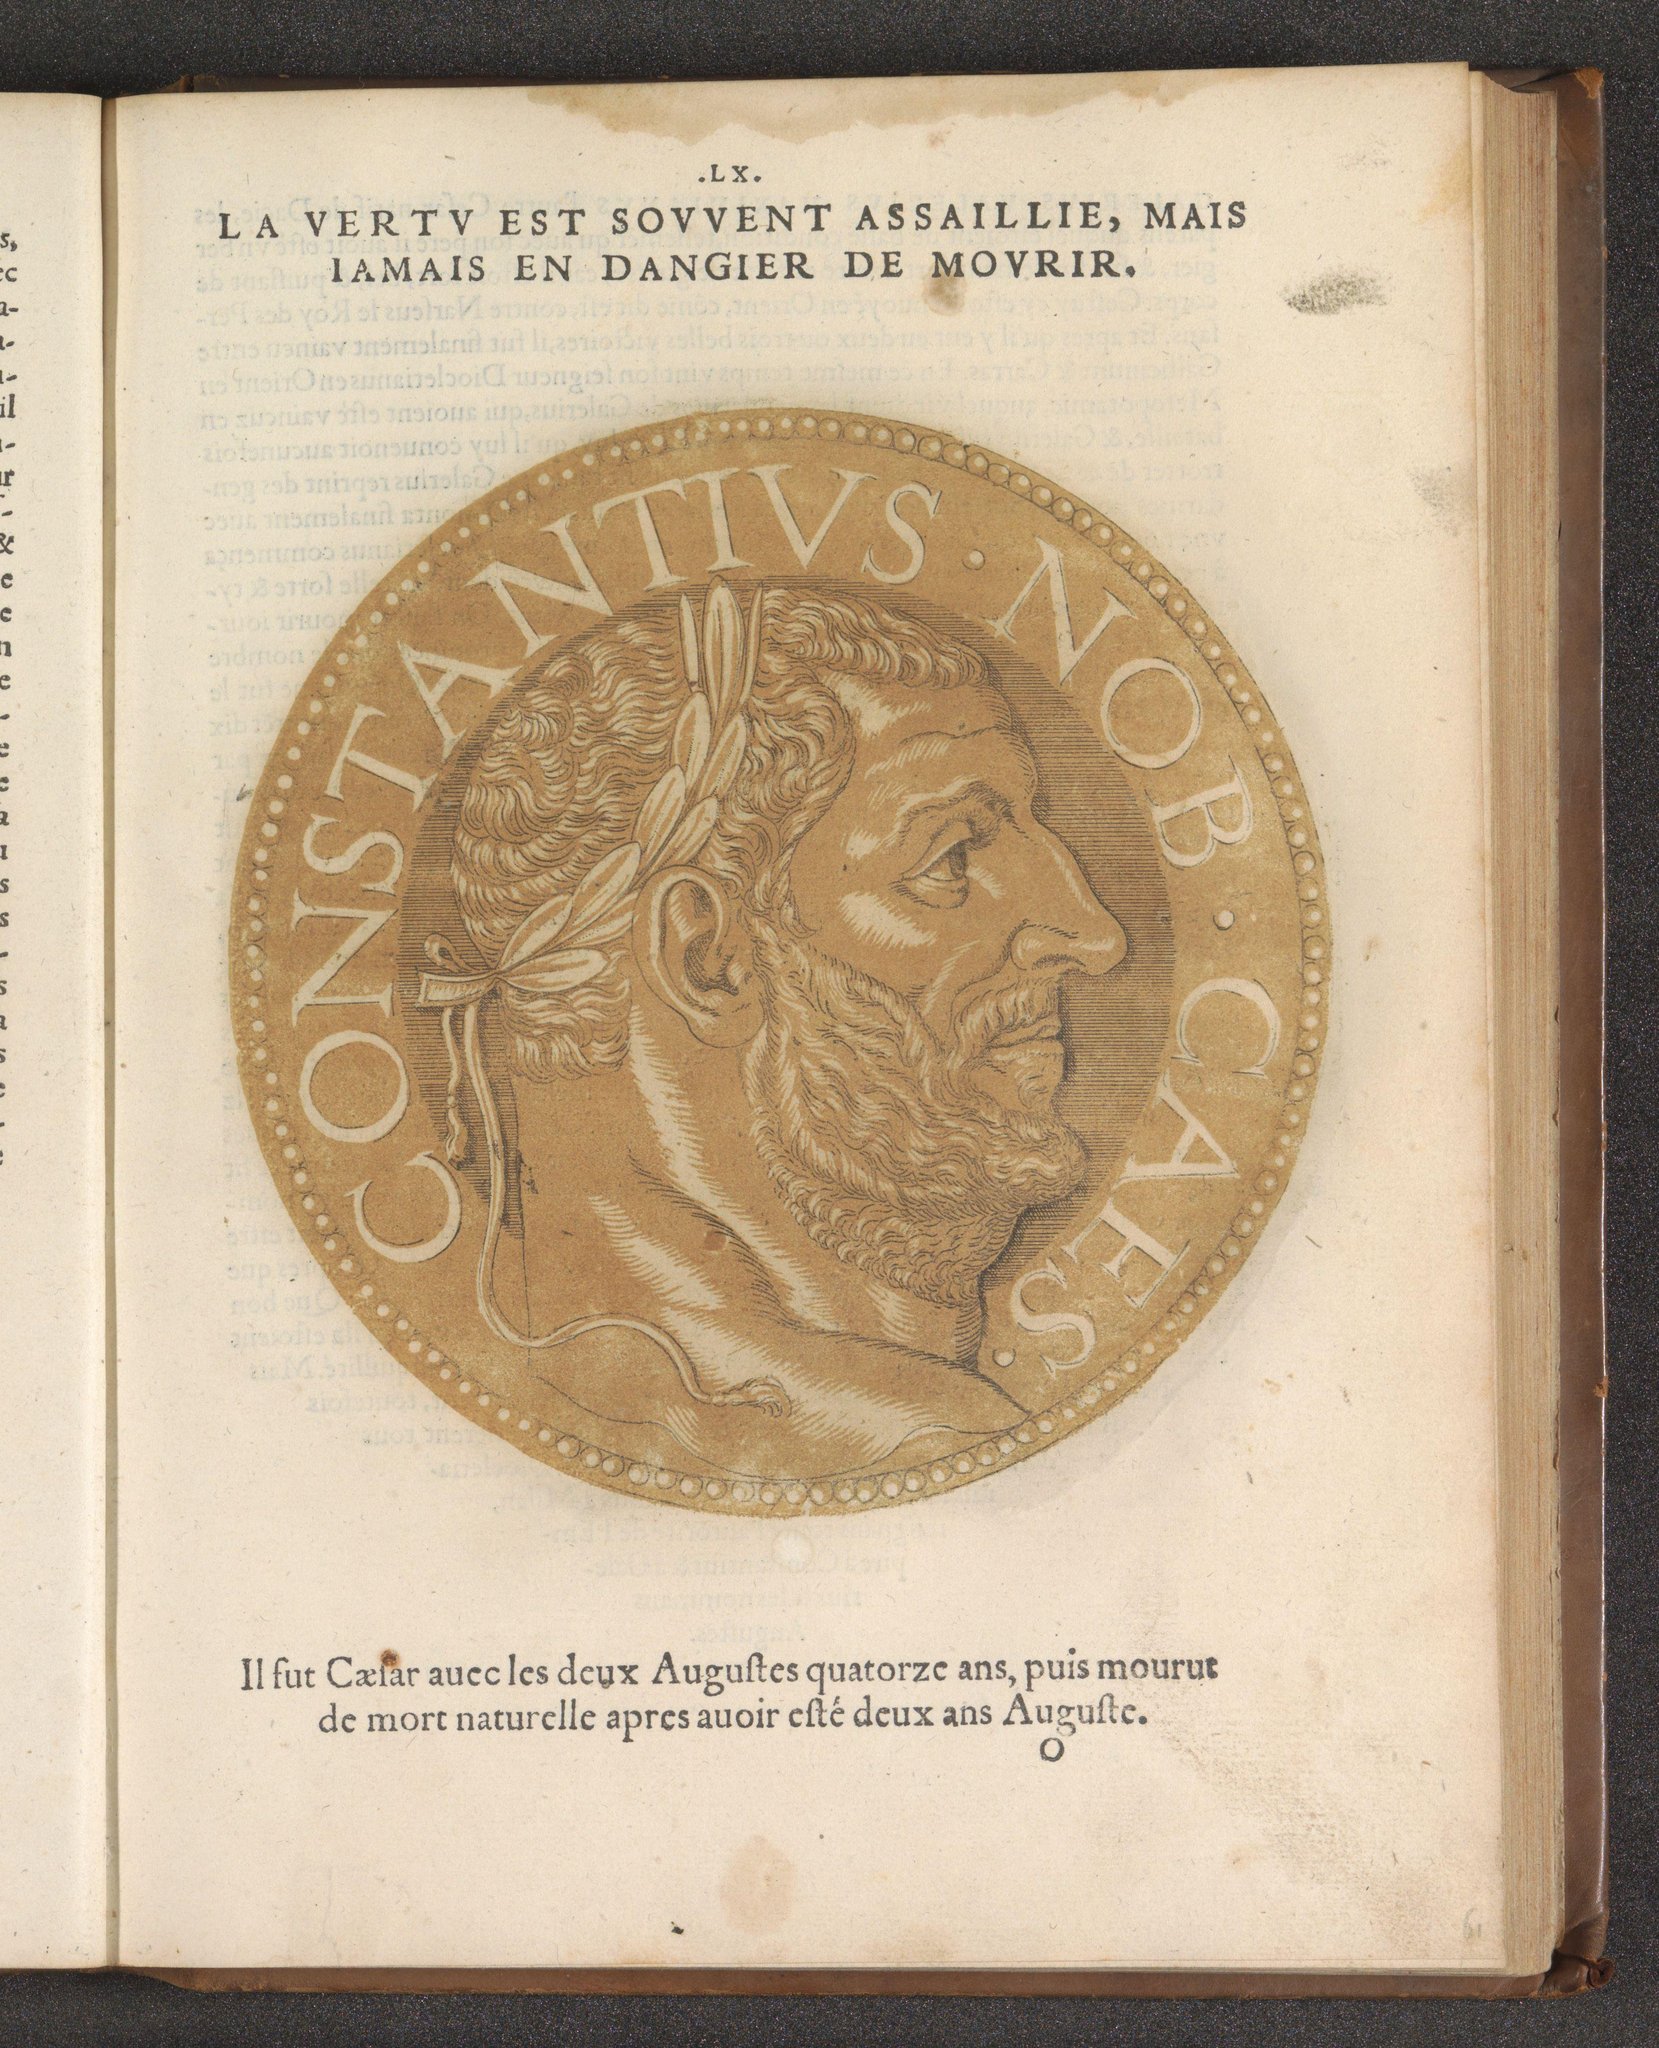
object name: print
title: Portret van keizer Constantius I Chlorus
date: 1557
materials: paper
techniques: woodcut, etching, letterpress printing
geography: antwerp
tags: emperor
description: Portret van keizer Constantius I Chlorus, op een munt met randschrift. De prent maakt deel uit van een boek over de keizers vanaf Julius Caesar tot en met Karel V en zijn broer Ferdinand.